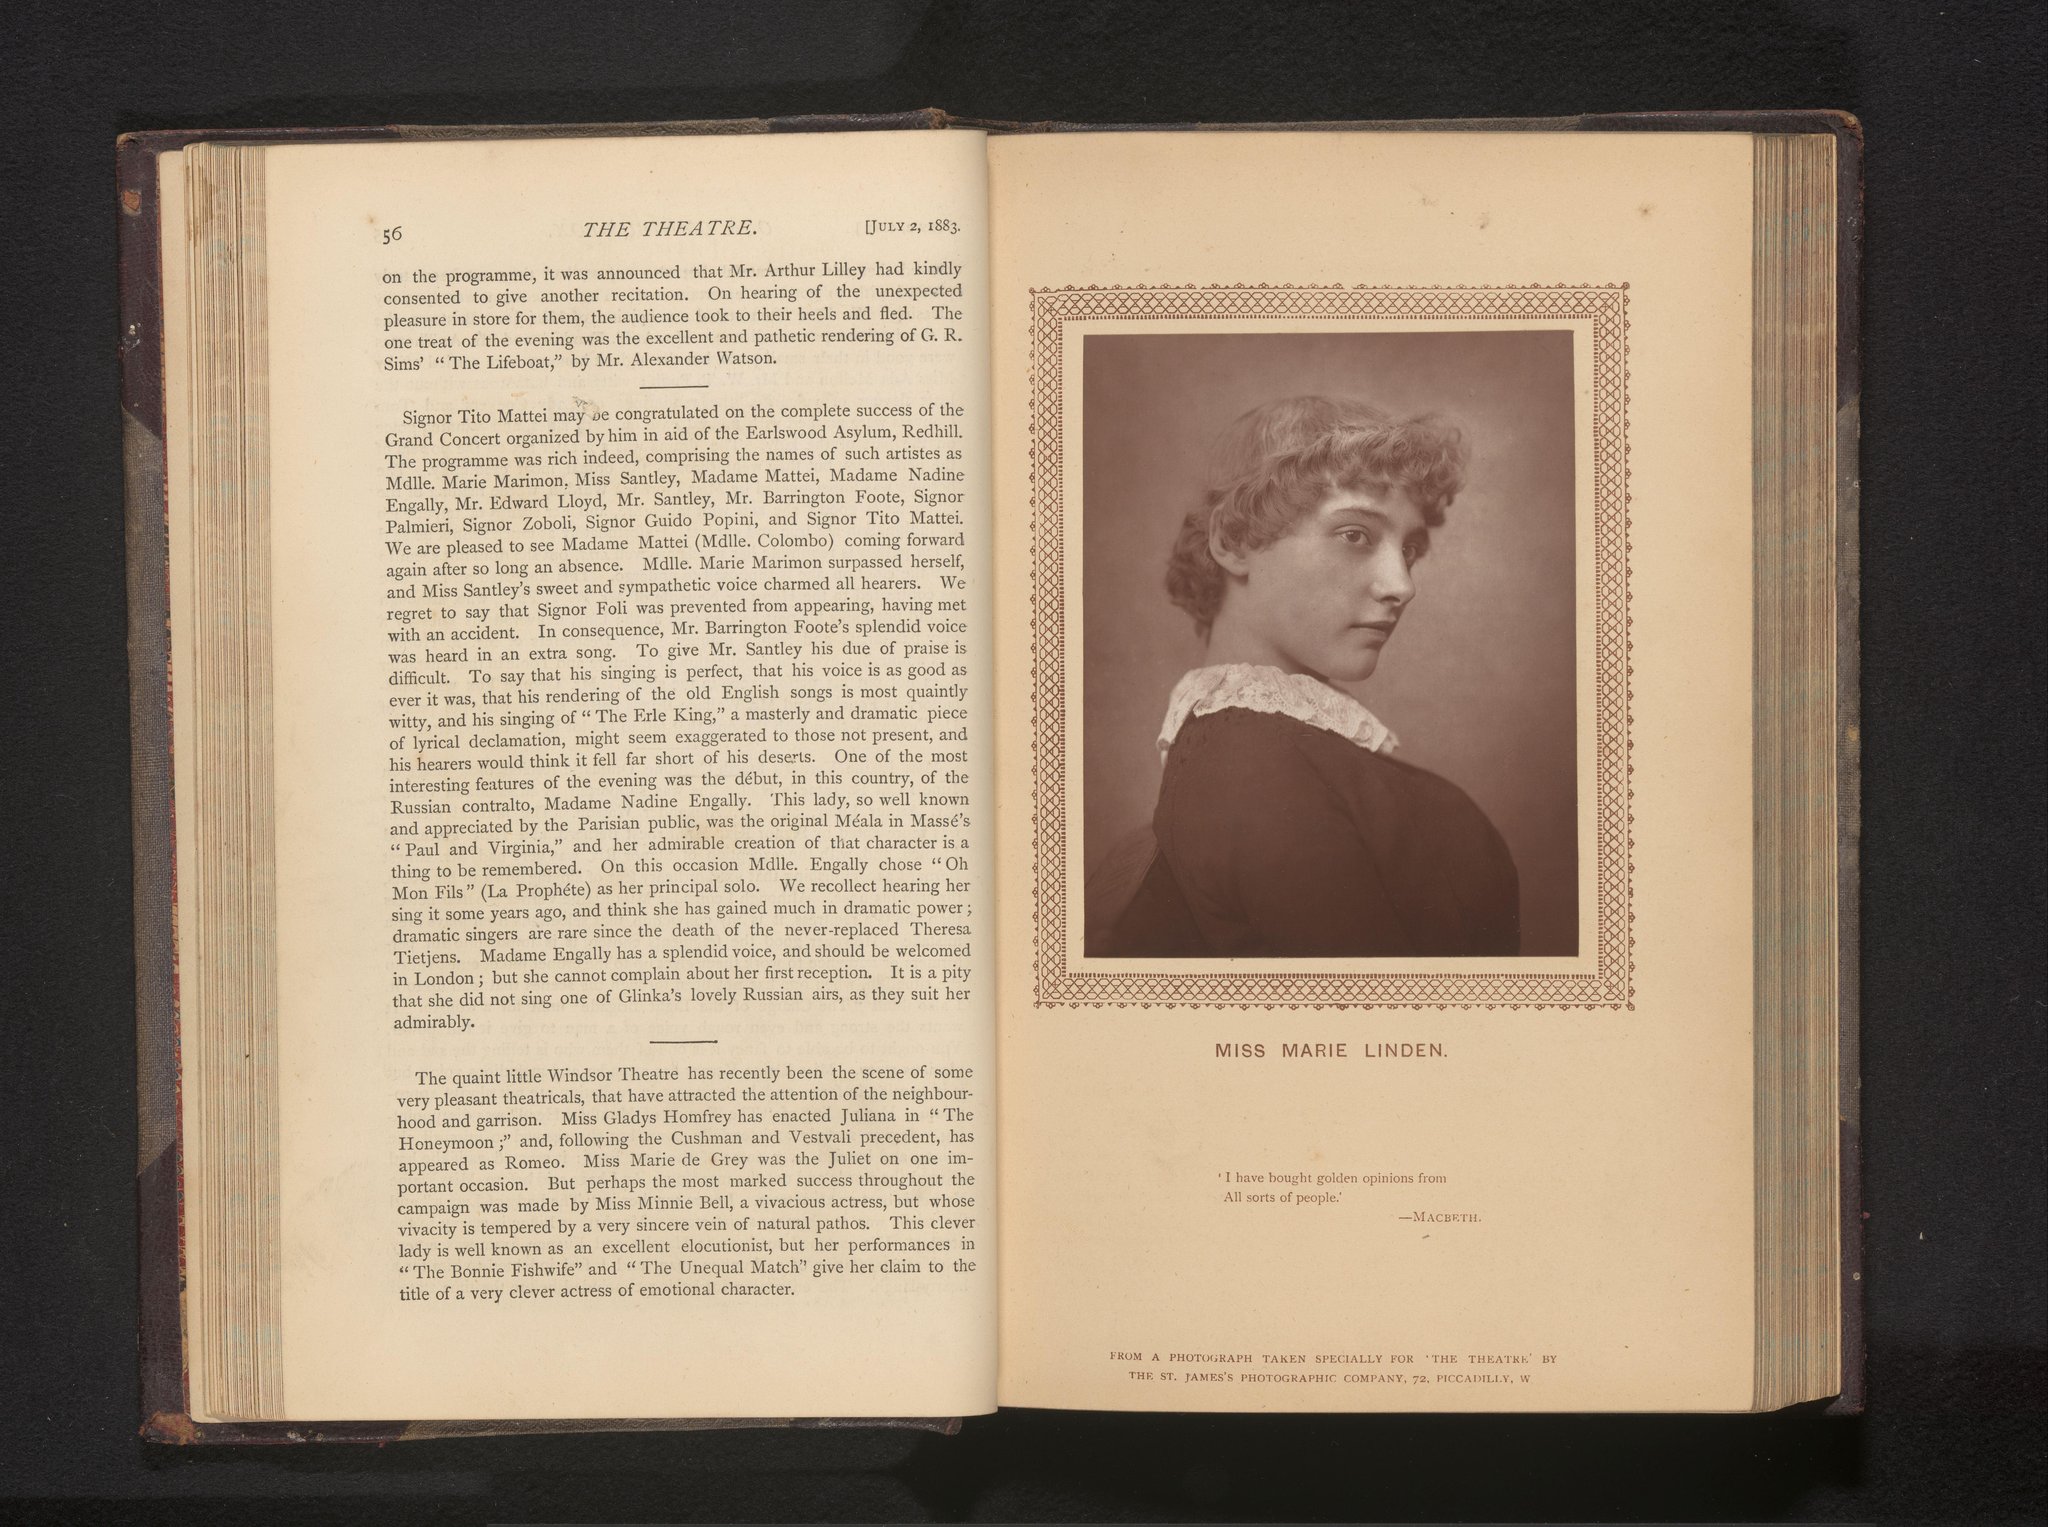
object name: page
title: Portret van Marie Linden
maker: Anonymous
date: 1878-1883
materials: paper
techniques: woodburytype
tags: adult woman, historical persons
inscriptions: inscription: ‘'I have bought golden opinions from/ all sorts of people.'/ -Macbeth.’